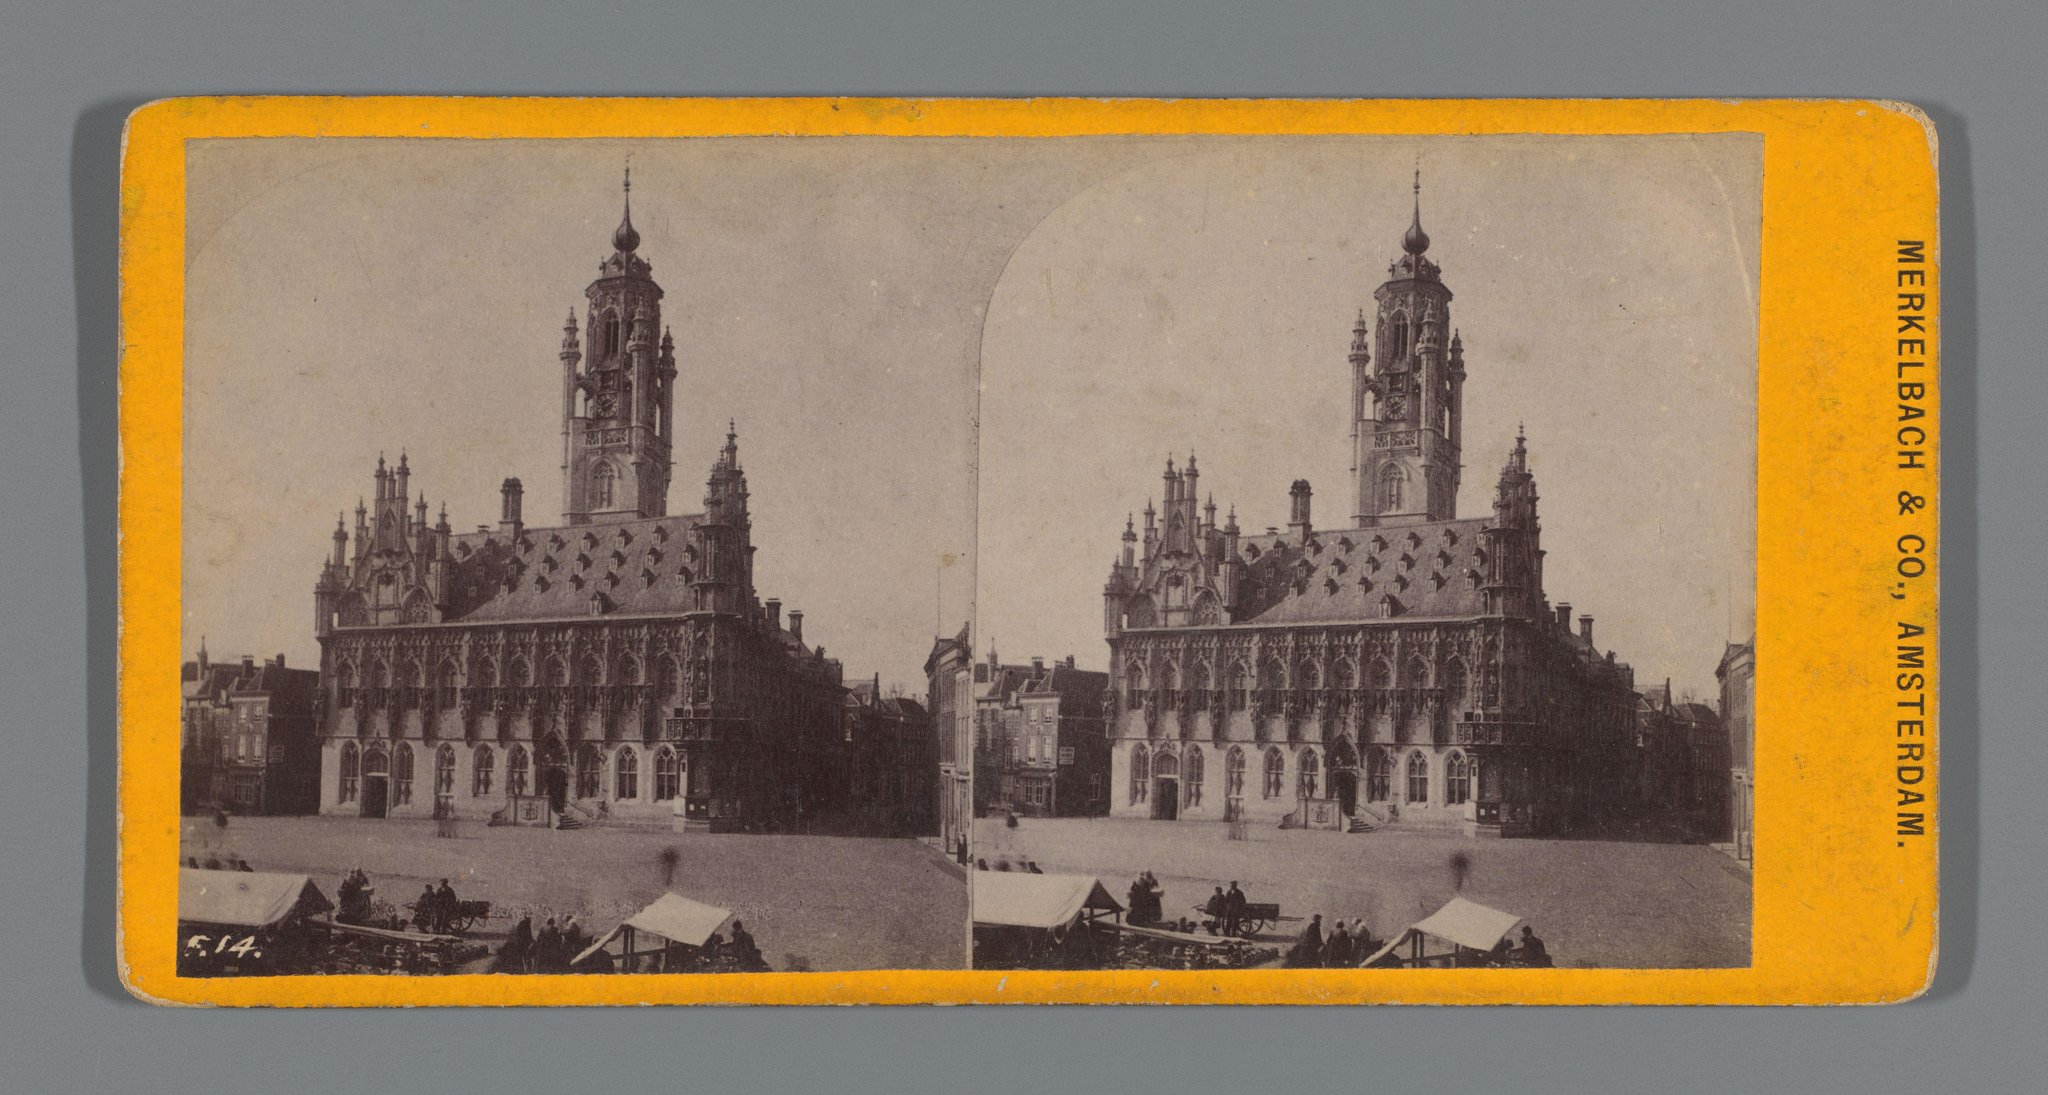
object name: stereograph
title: Aardrijkskundige Beeldengalerij, verzameld door M.J. Broekhuijsen, Hoofd eener school te Amsterdam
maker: martien johan broekhuijsen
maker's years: 1871-1956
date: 1905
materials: photographic support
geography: amsterdam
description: Onderdeel van een groep van 52 stereofoto's gebruikt in het lager onderwijs als aanvulling op schoolplaten. De gehele reeks bestond uit 274 nummers in 10 categorieën (A t/m K).